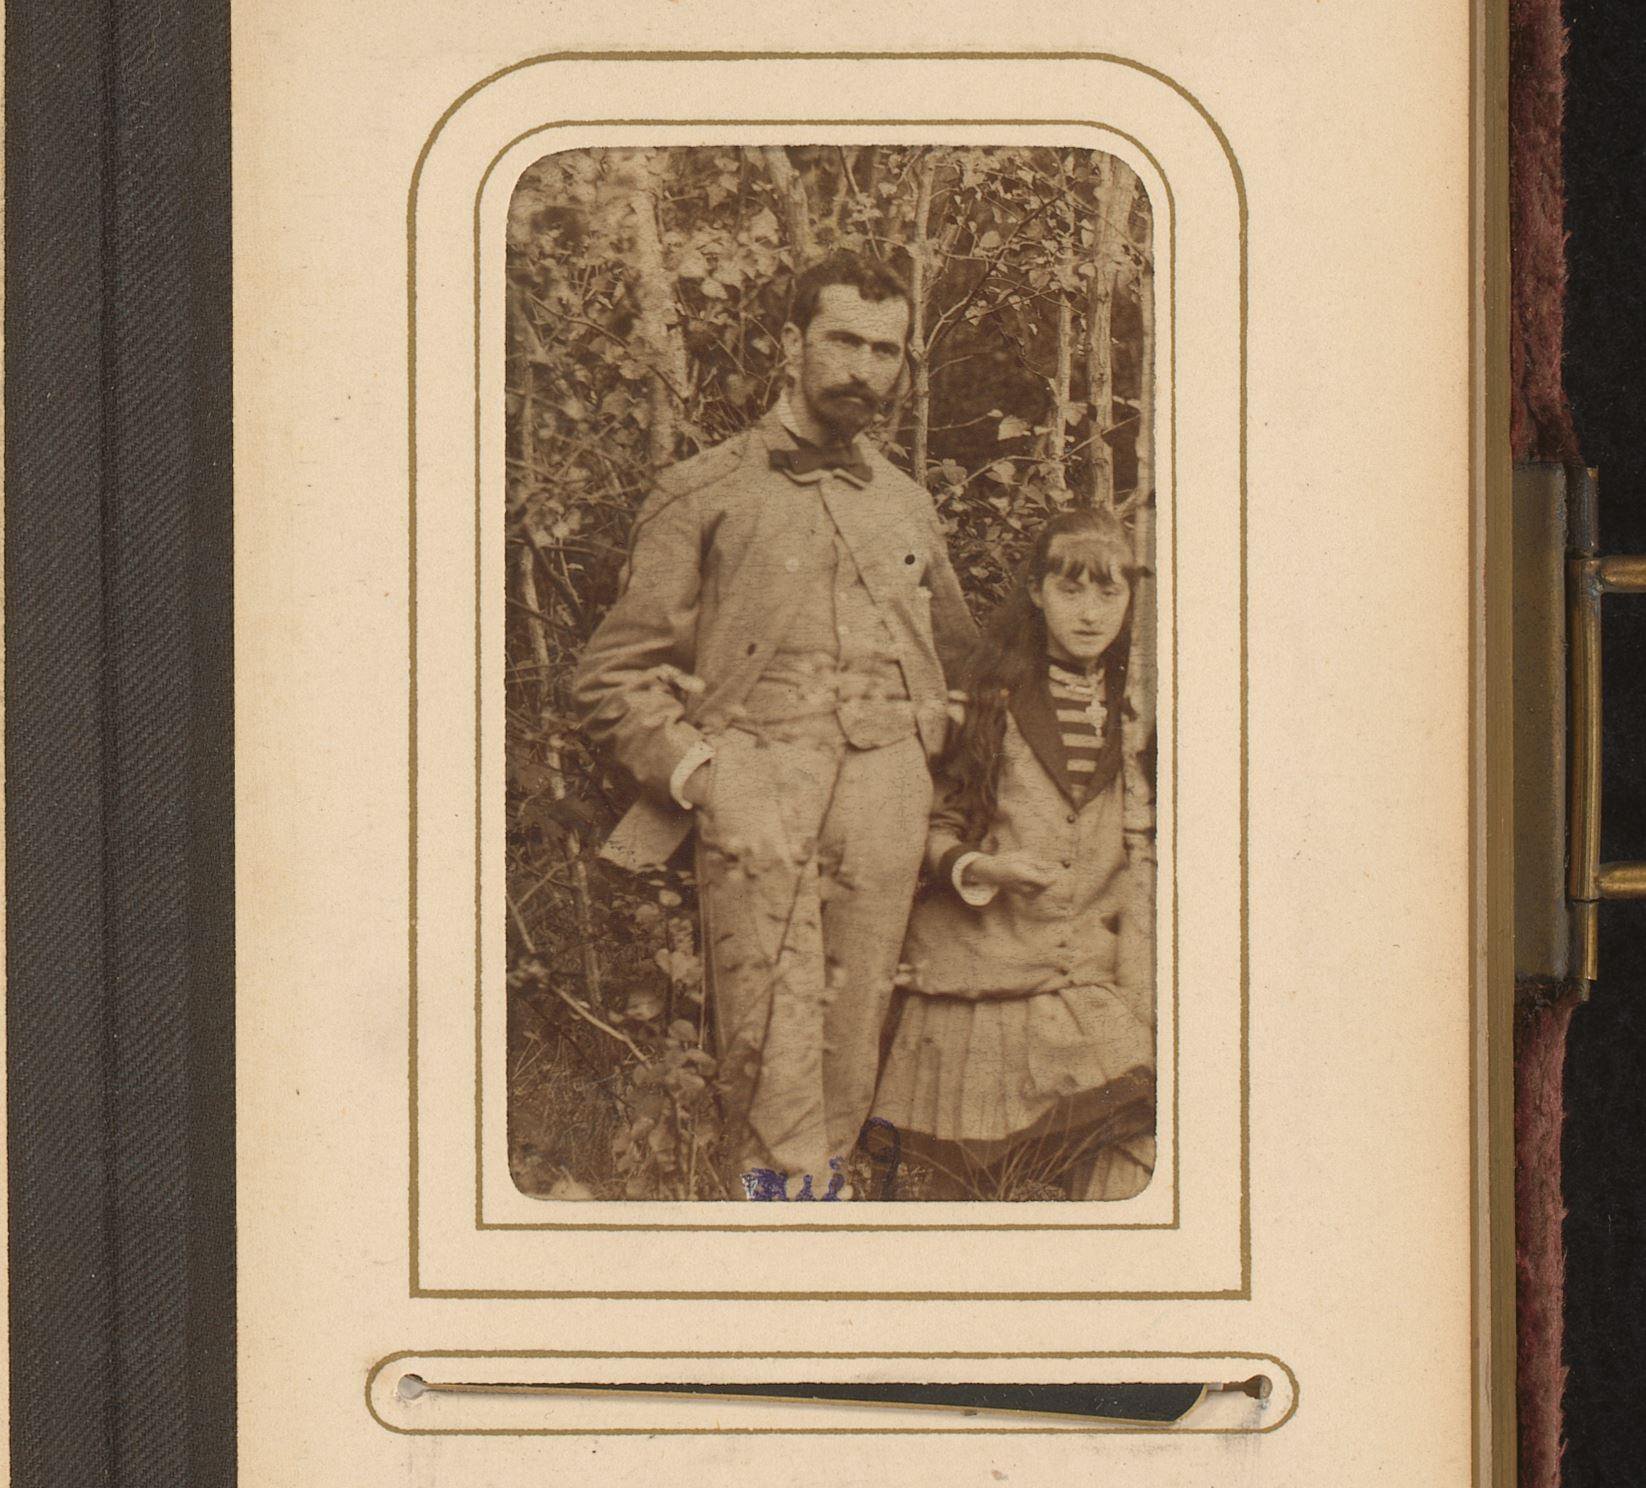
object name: photograph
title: Portret van een man en meisje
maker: Anonymous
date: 1860-1900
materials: cardboard, photographic support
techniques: albumen print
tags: trees, adult man, historical persons, girl (child between toddler and youth)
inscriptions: annotation: ‘qui?’